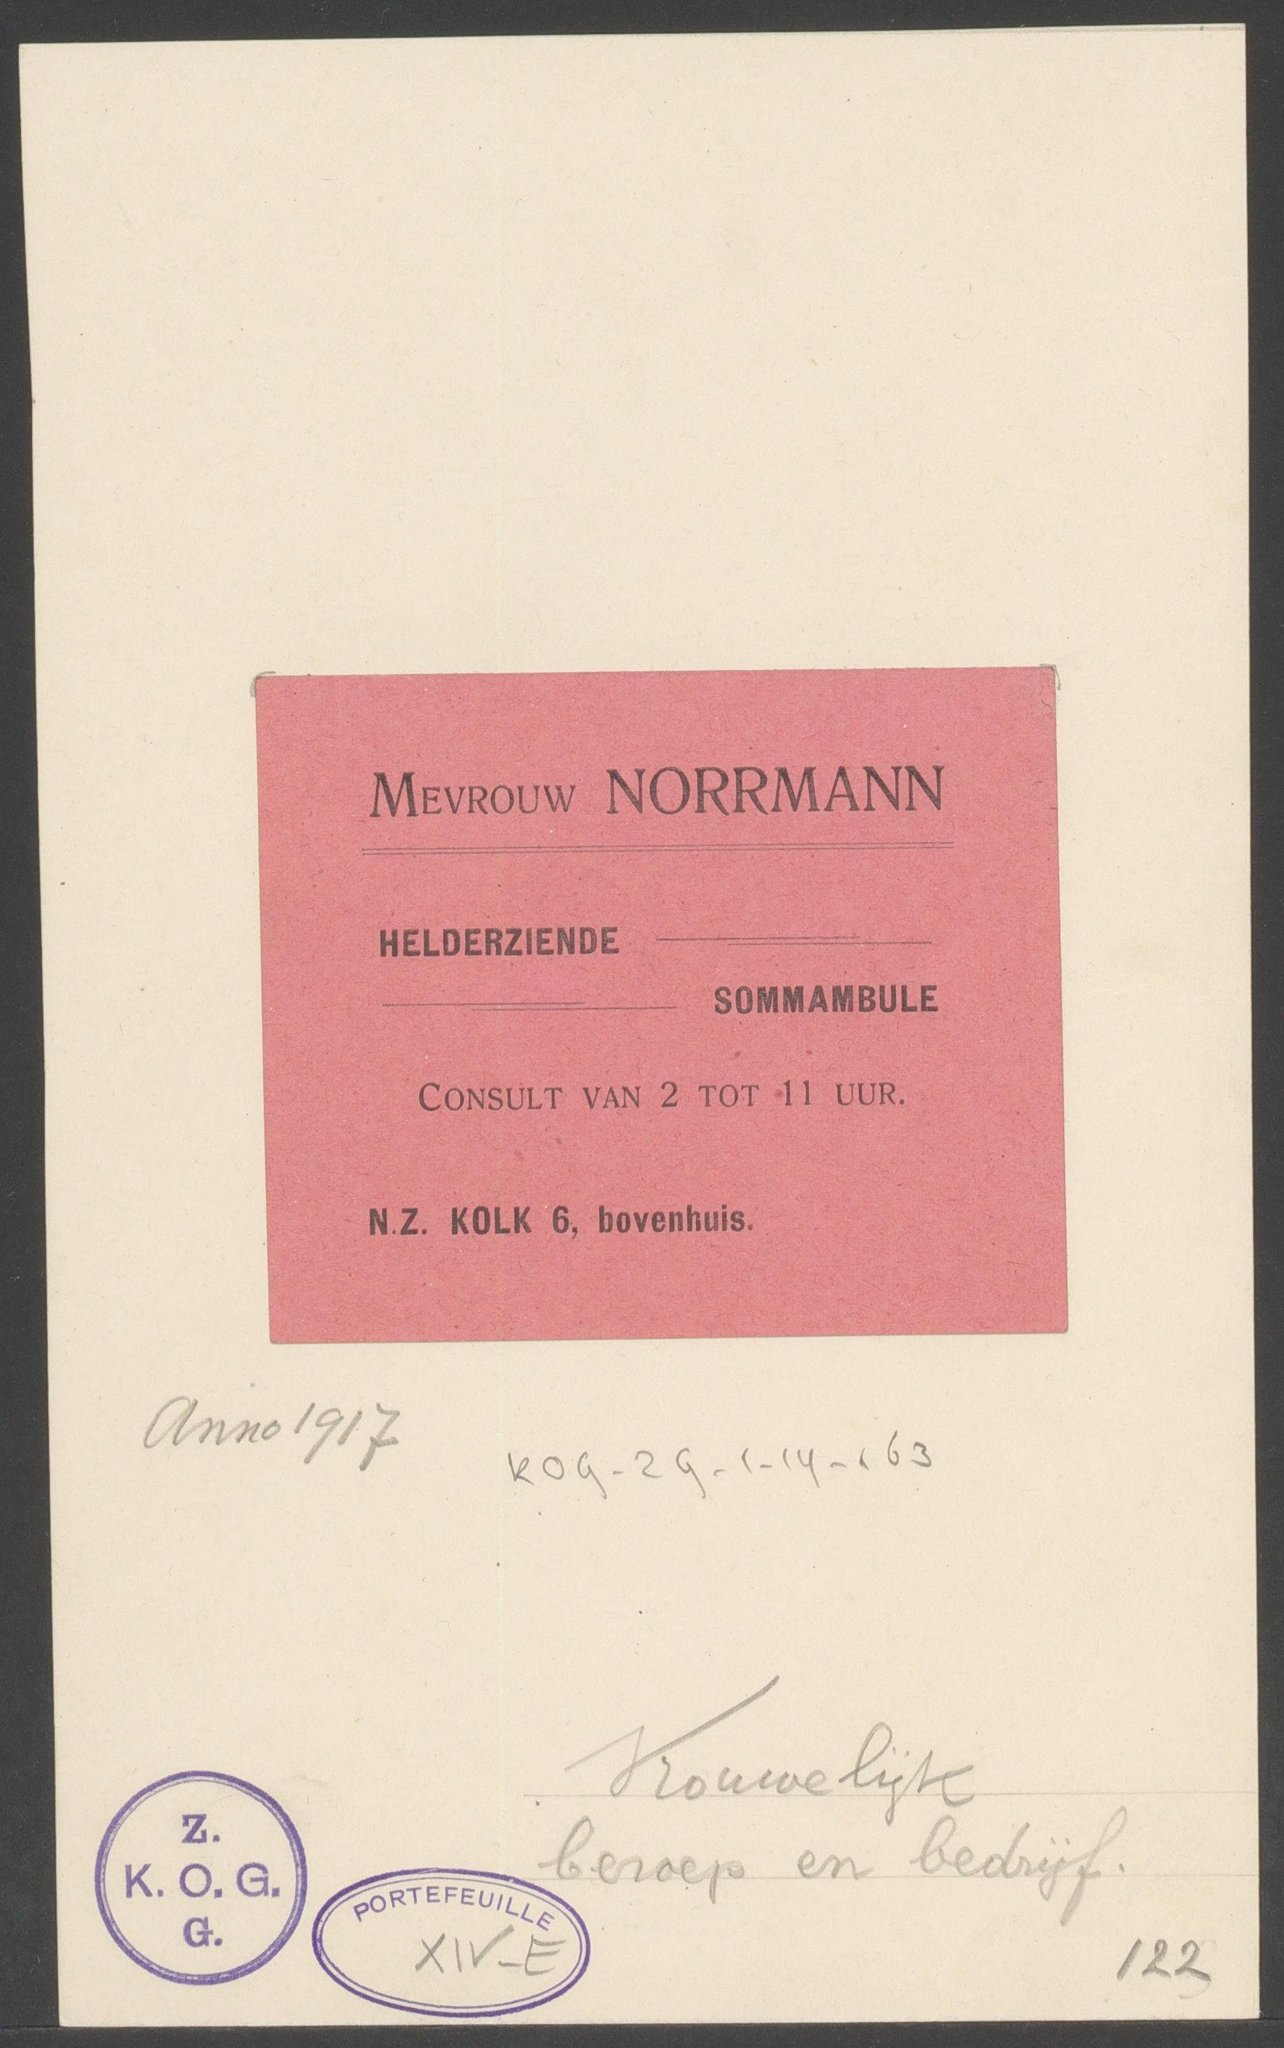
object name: business card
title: Mevrouw Norrmann Helderziende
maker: Anonymous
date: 1917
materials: paper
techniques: letterpress printing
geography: netherlands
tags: divination, prognostication ~ magic, fortune-teller ~ pleasure fair and circus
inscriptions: collector's mark: Lugt 1641, collector's mark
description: Adreskaartje van de helderziende mevrouw Norrmann op de Nieuwezijds Kolk nr. 6 te Amsterdam. Onderwerpsrubrieken binnen de Atlas Zeden en Gewoonten: Beroep en bedrijf. Vrouwelijk beroep en bedrijf. Waarzegsters.